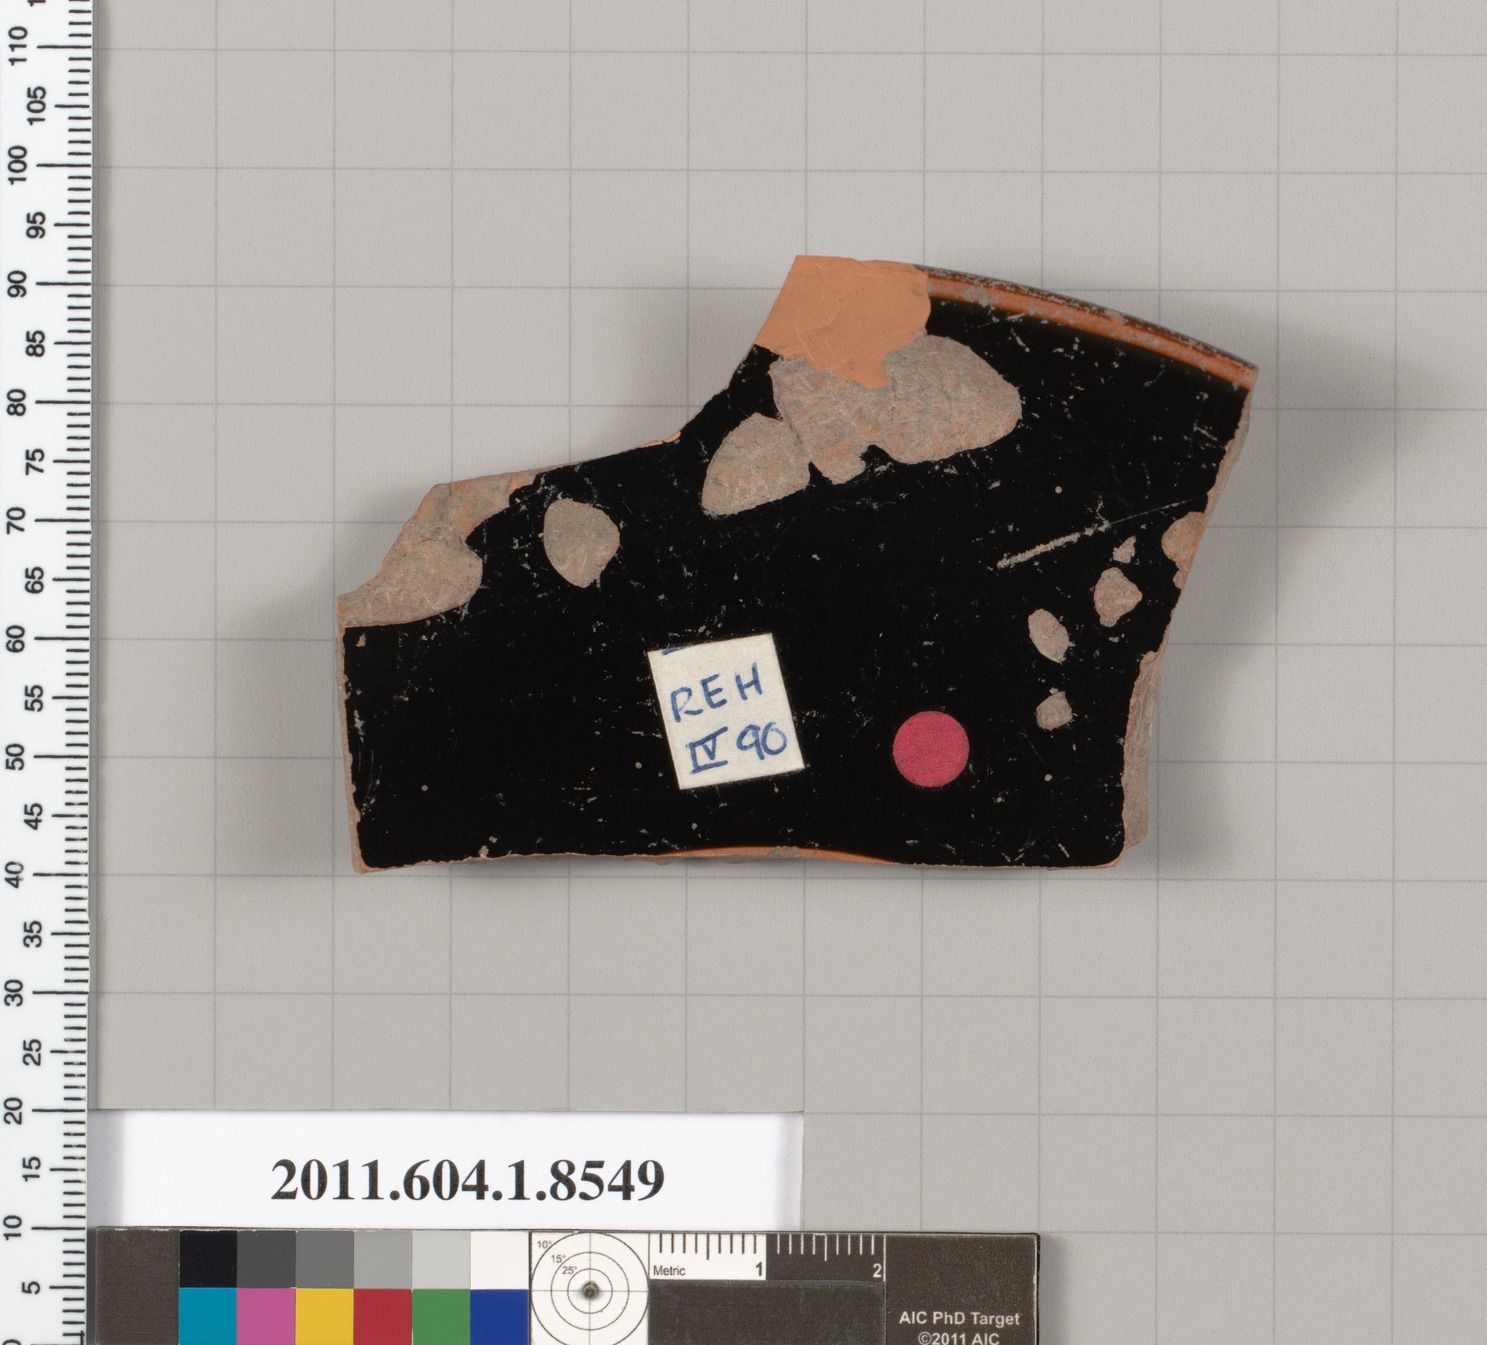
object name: kylix fragment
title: Terracotta rim fragment of a stemless kylix (drinking cup)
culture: greek, attic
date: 470-450 BCE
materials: terracotta